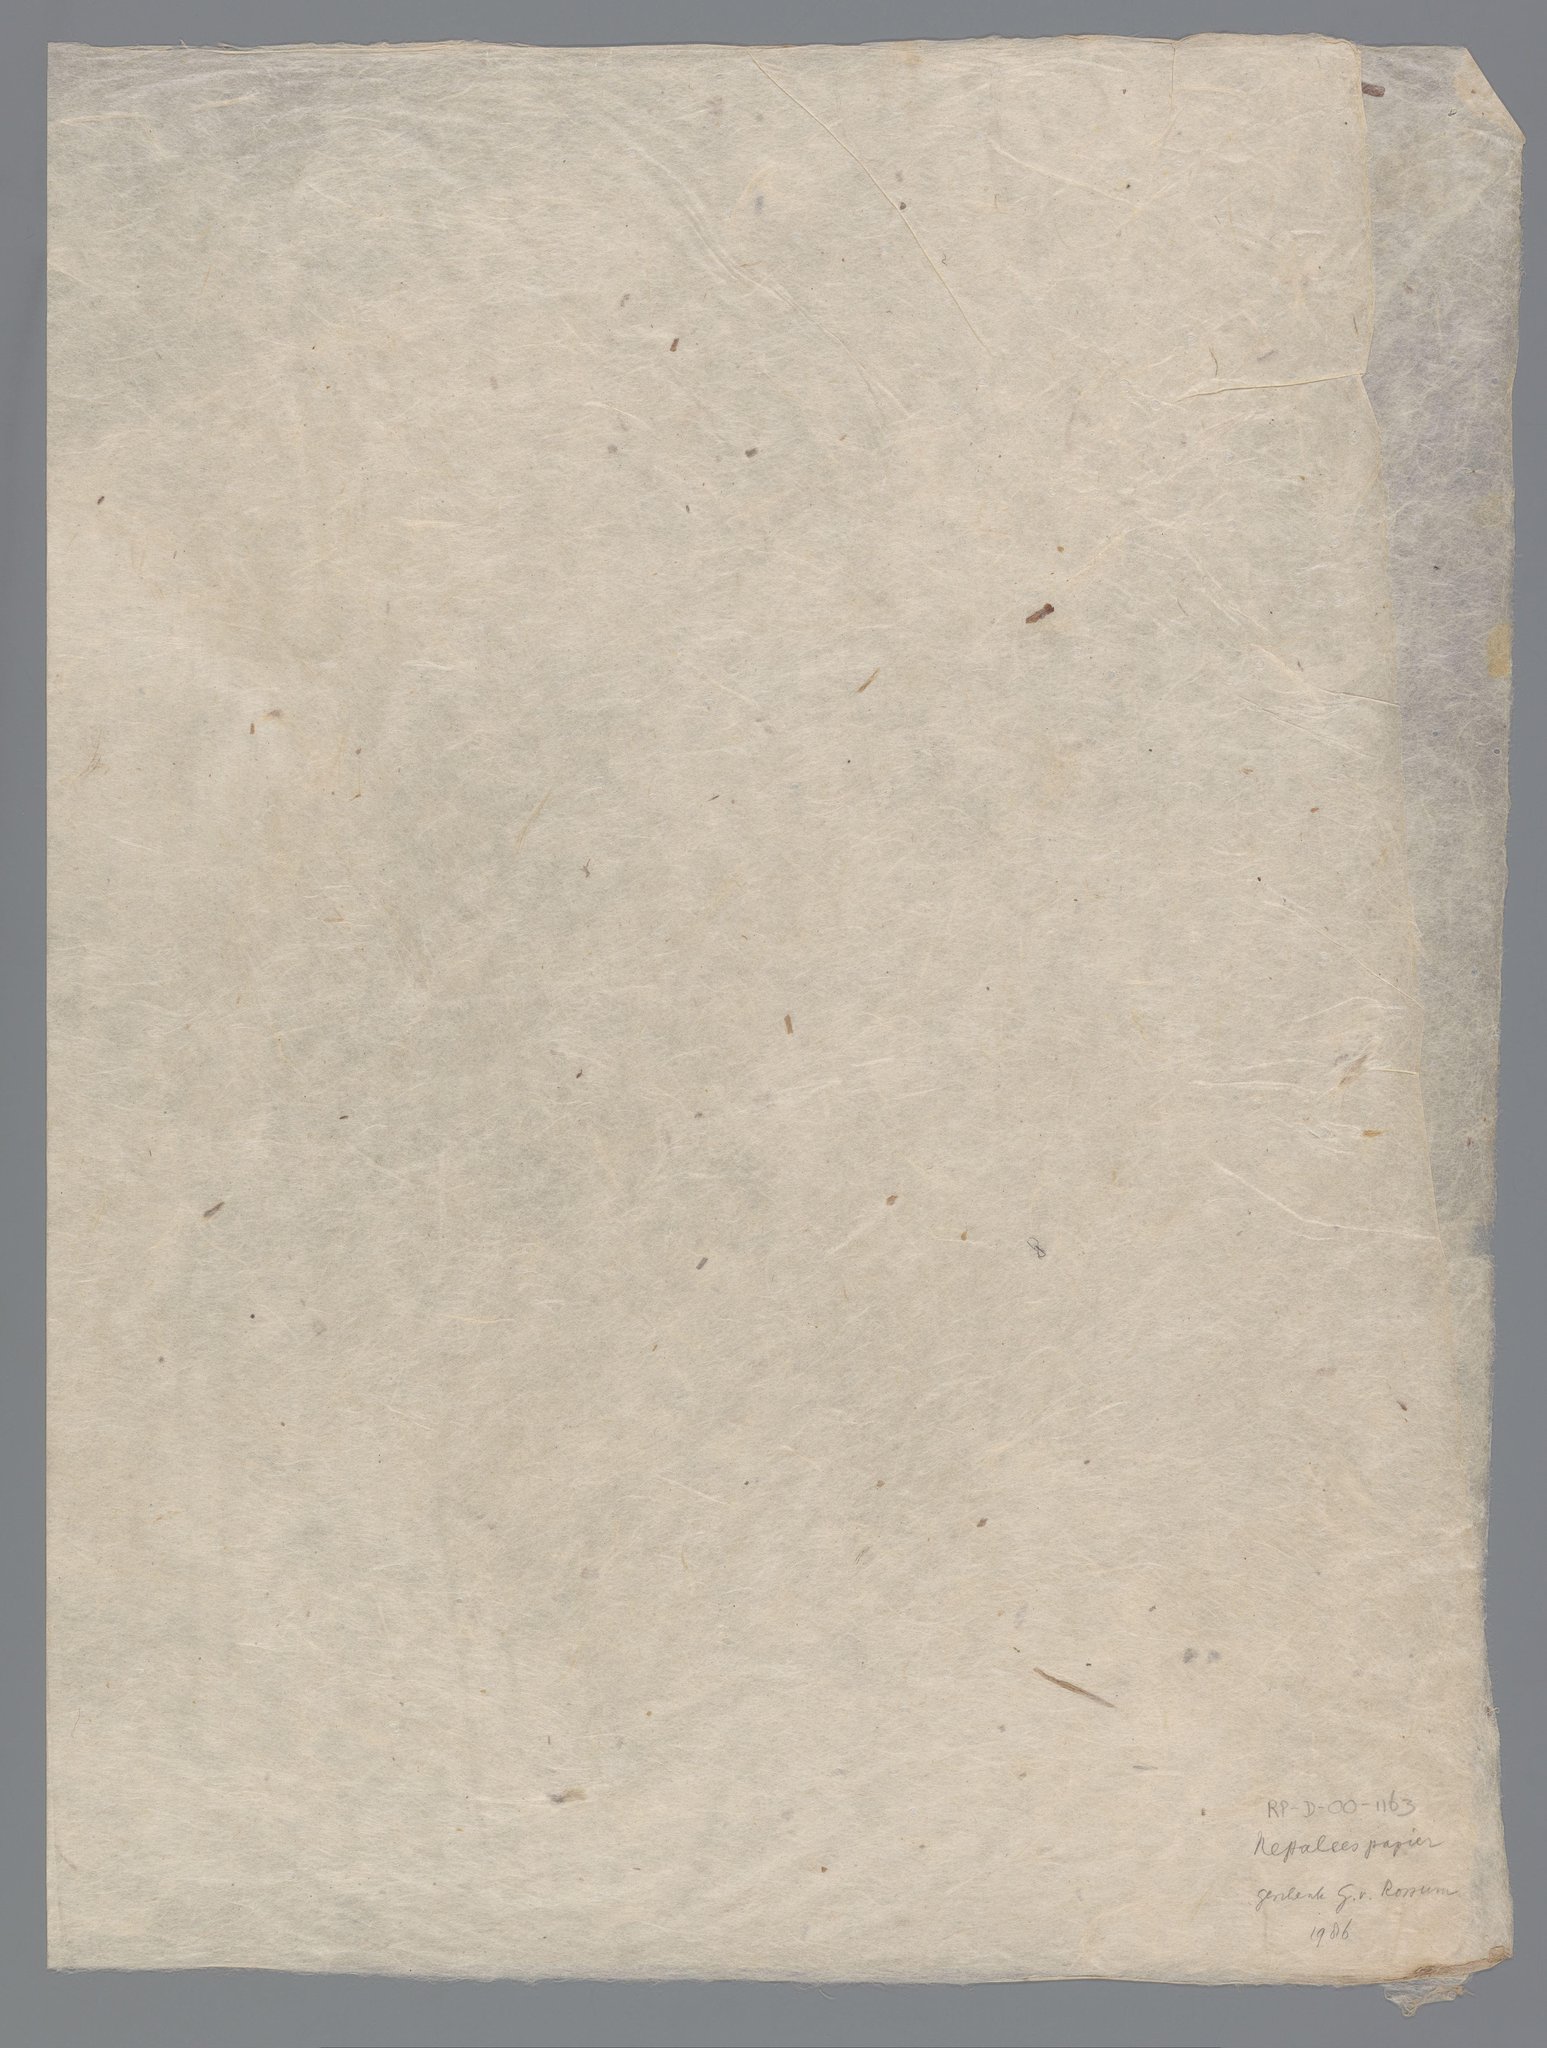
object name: decorated paper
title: Blad Nepalees papier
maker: Anonymous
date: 1950-1986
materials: paper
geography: nepal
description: Dubbelgevouwen blad Nepalees papier met allerlei insluitsels zoals stukjes gras, zaadjes, etc. Onbedrukt, halfdoorzichtig.